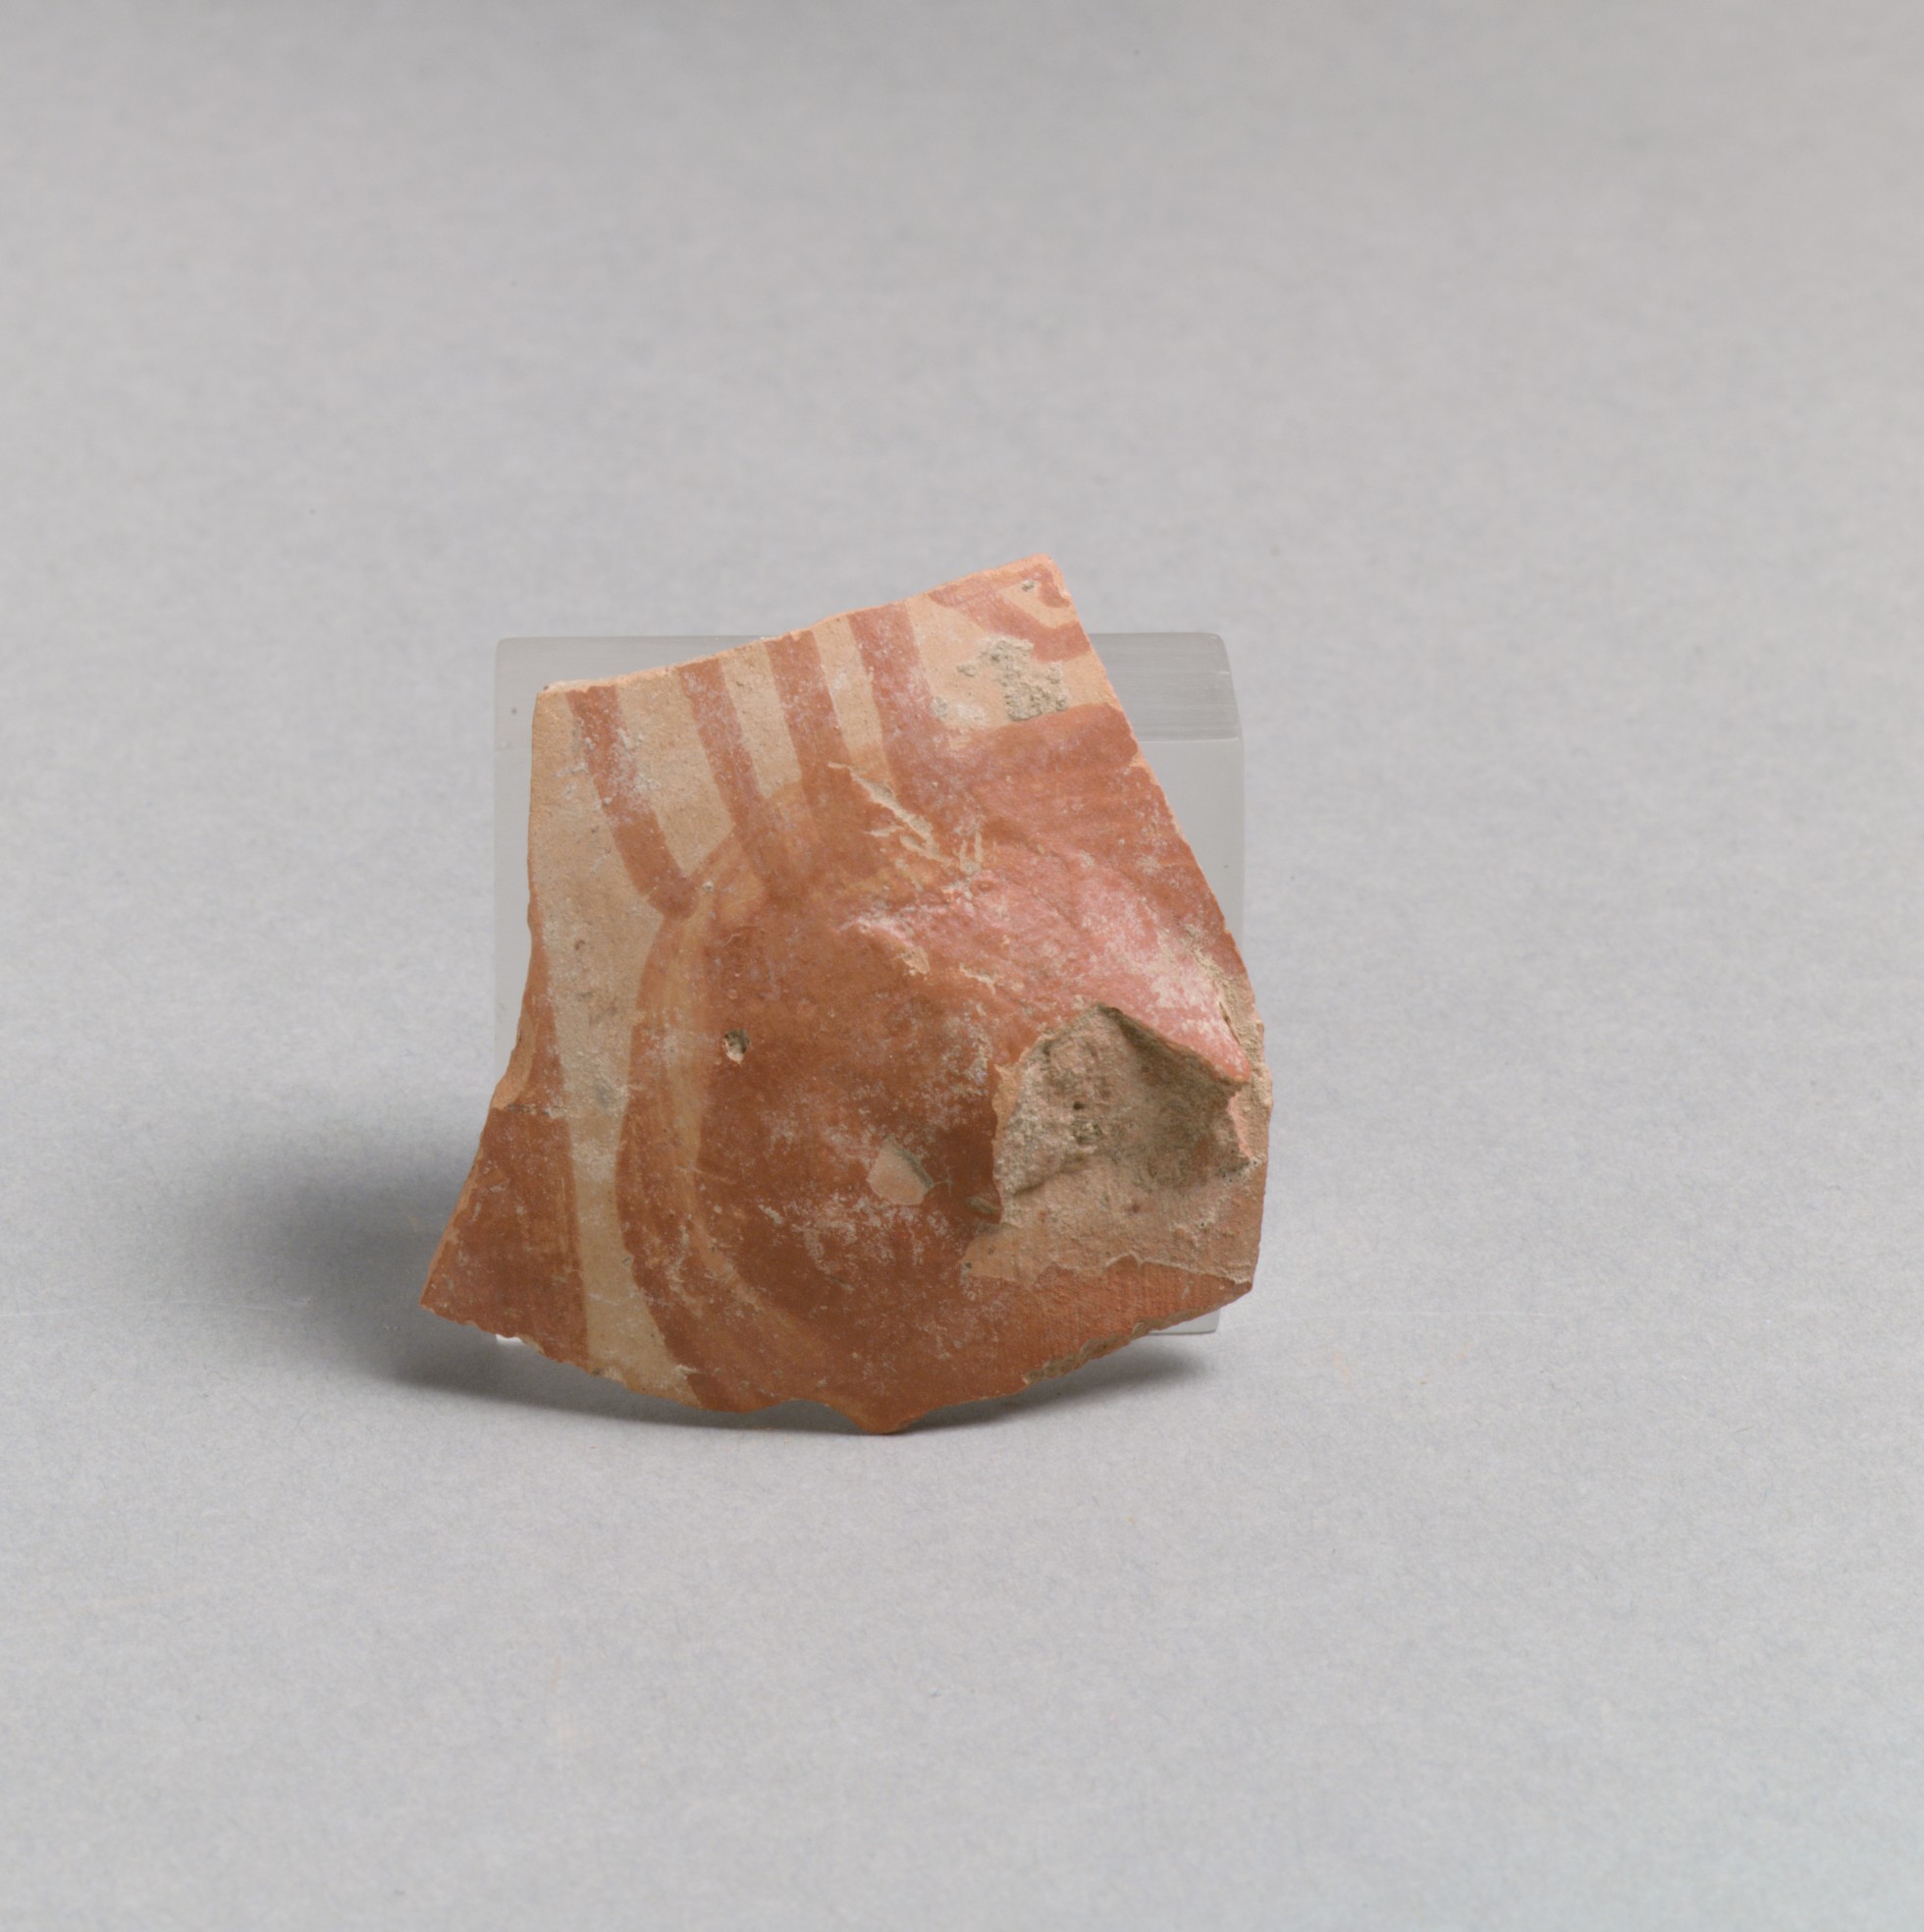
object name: vase fragment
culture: greek, laconian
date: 2000-1550 BCE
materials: terracotta